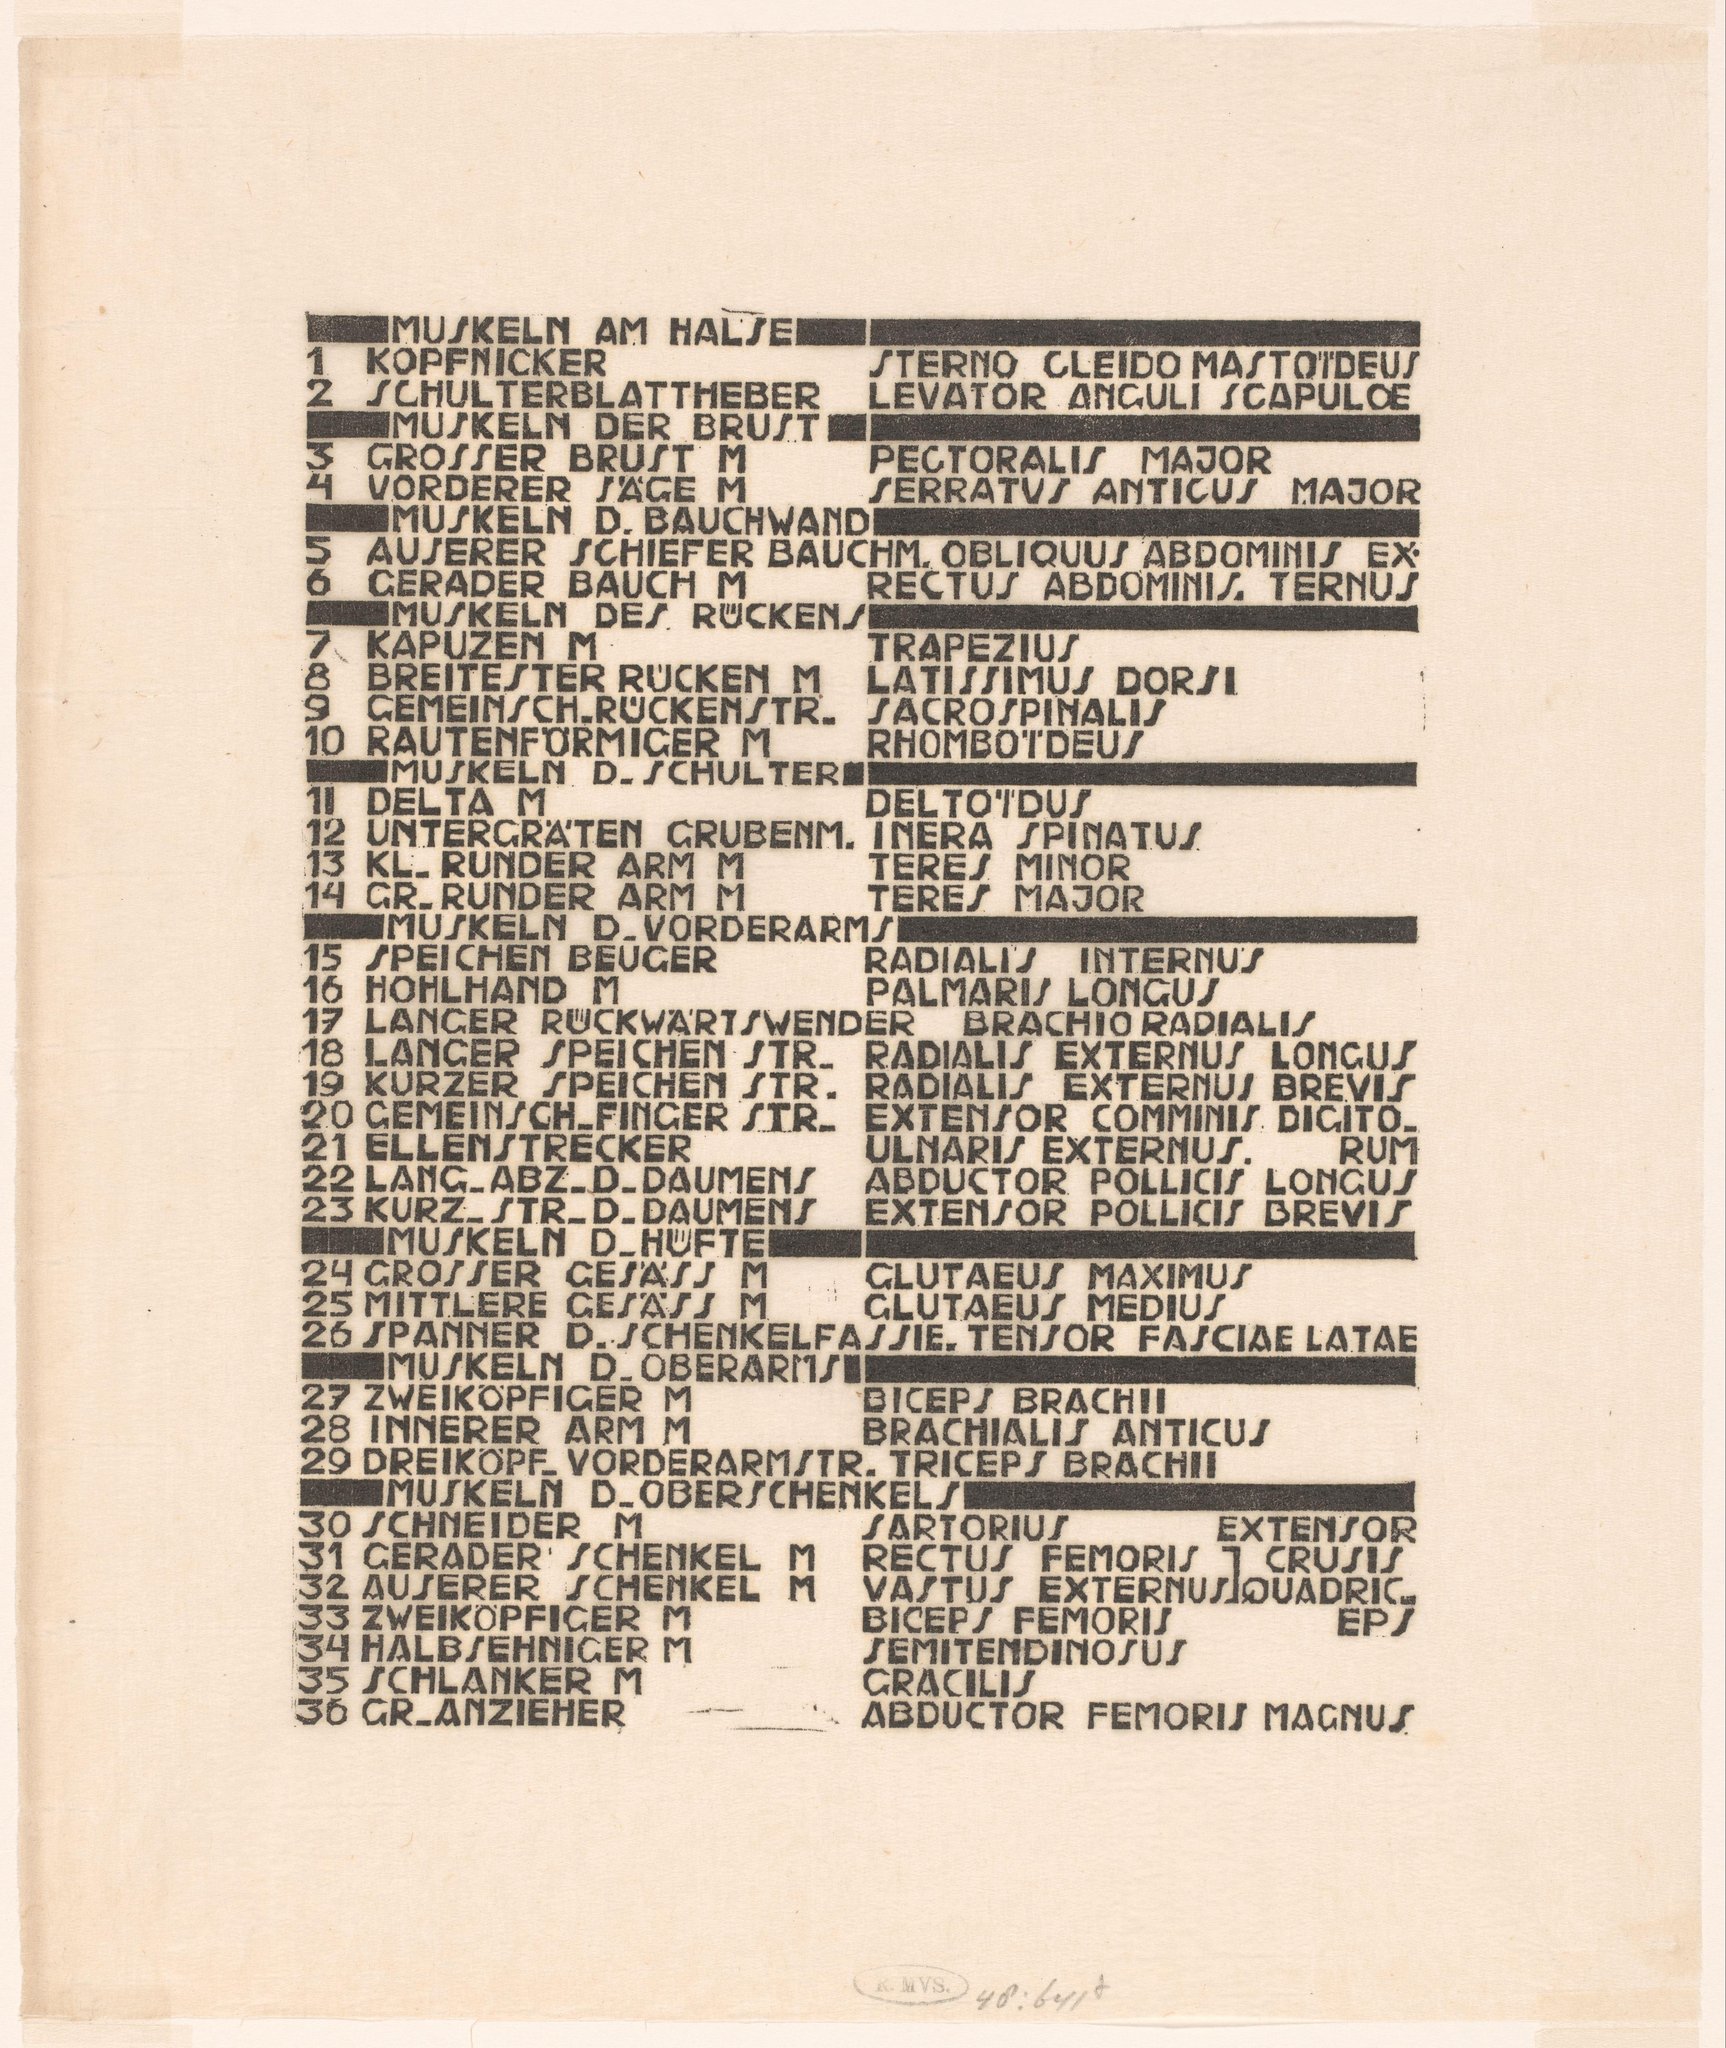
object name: print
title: Lijst van rug-, arm- en bilspieren in Duits en Latijn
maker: reijer stolk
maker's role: draughtsman, print maker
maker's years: 1896-1945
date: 1906-1945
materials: paper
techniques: woodcut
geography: netherlands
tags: muscles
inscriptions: collector's mark: Lugt 2228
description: Prent gebruikt voor: Stolk, Reyer. Anatomische studies in houtsneden. Amsterdam: G.W. Breughel, 1946, plaat 1.